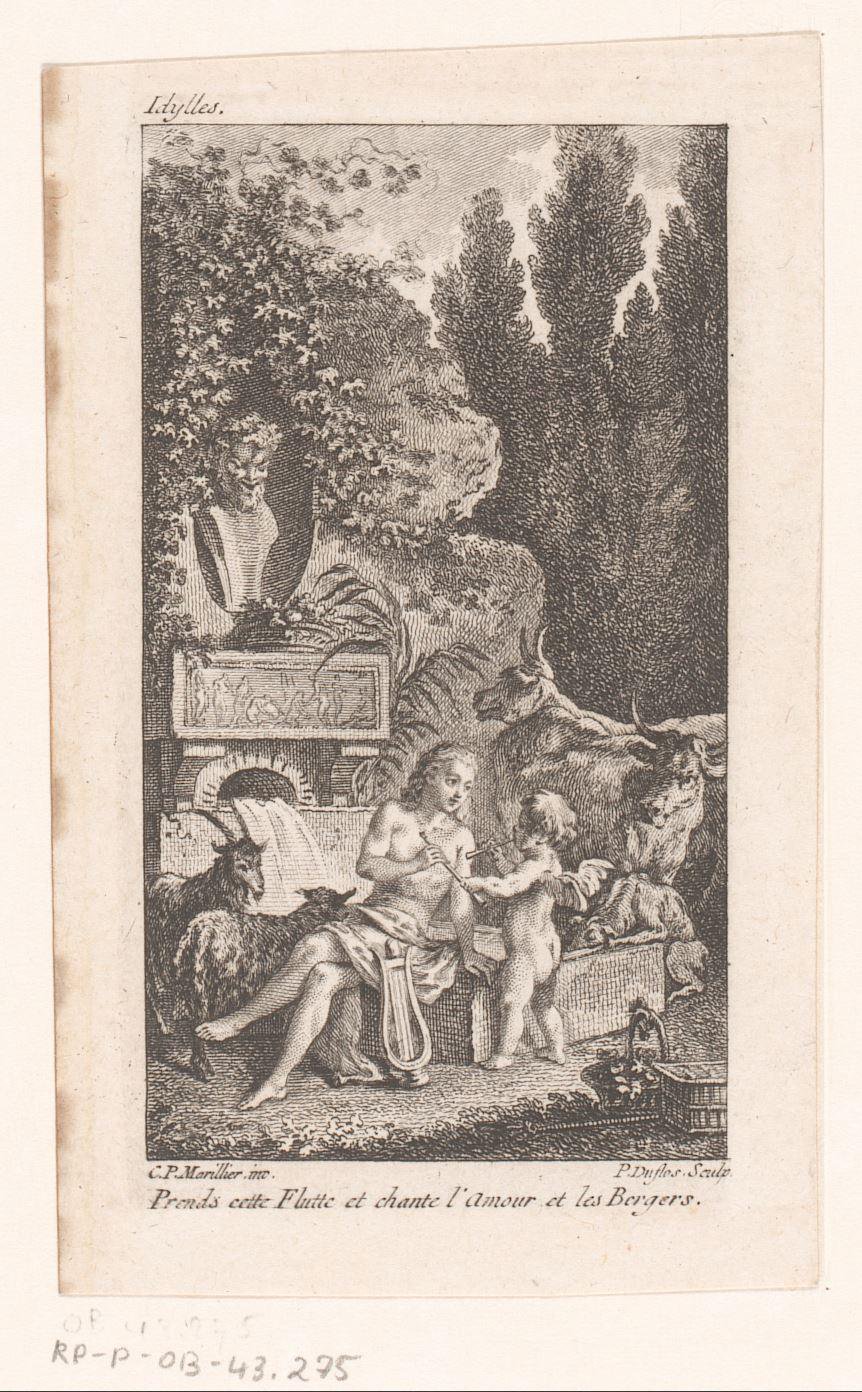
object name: book illustration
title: Amor en herder met kudde bij bron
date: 1785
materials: paper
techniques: engraving, etching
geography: paris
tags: (story of) cupid, amor (eros), pastorals, arcadian scenes, herd, flock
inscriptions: collector's mark: Lugt 2228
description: Prent uit: Gessner. Oeuvres. Parijs: Hubert-Martin Cazin, s.a.